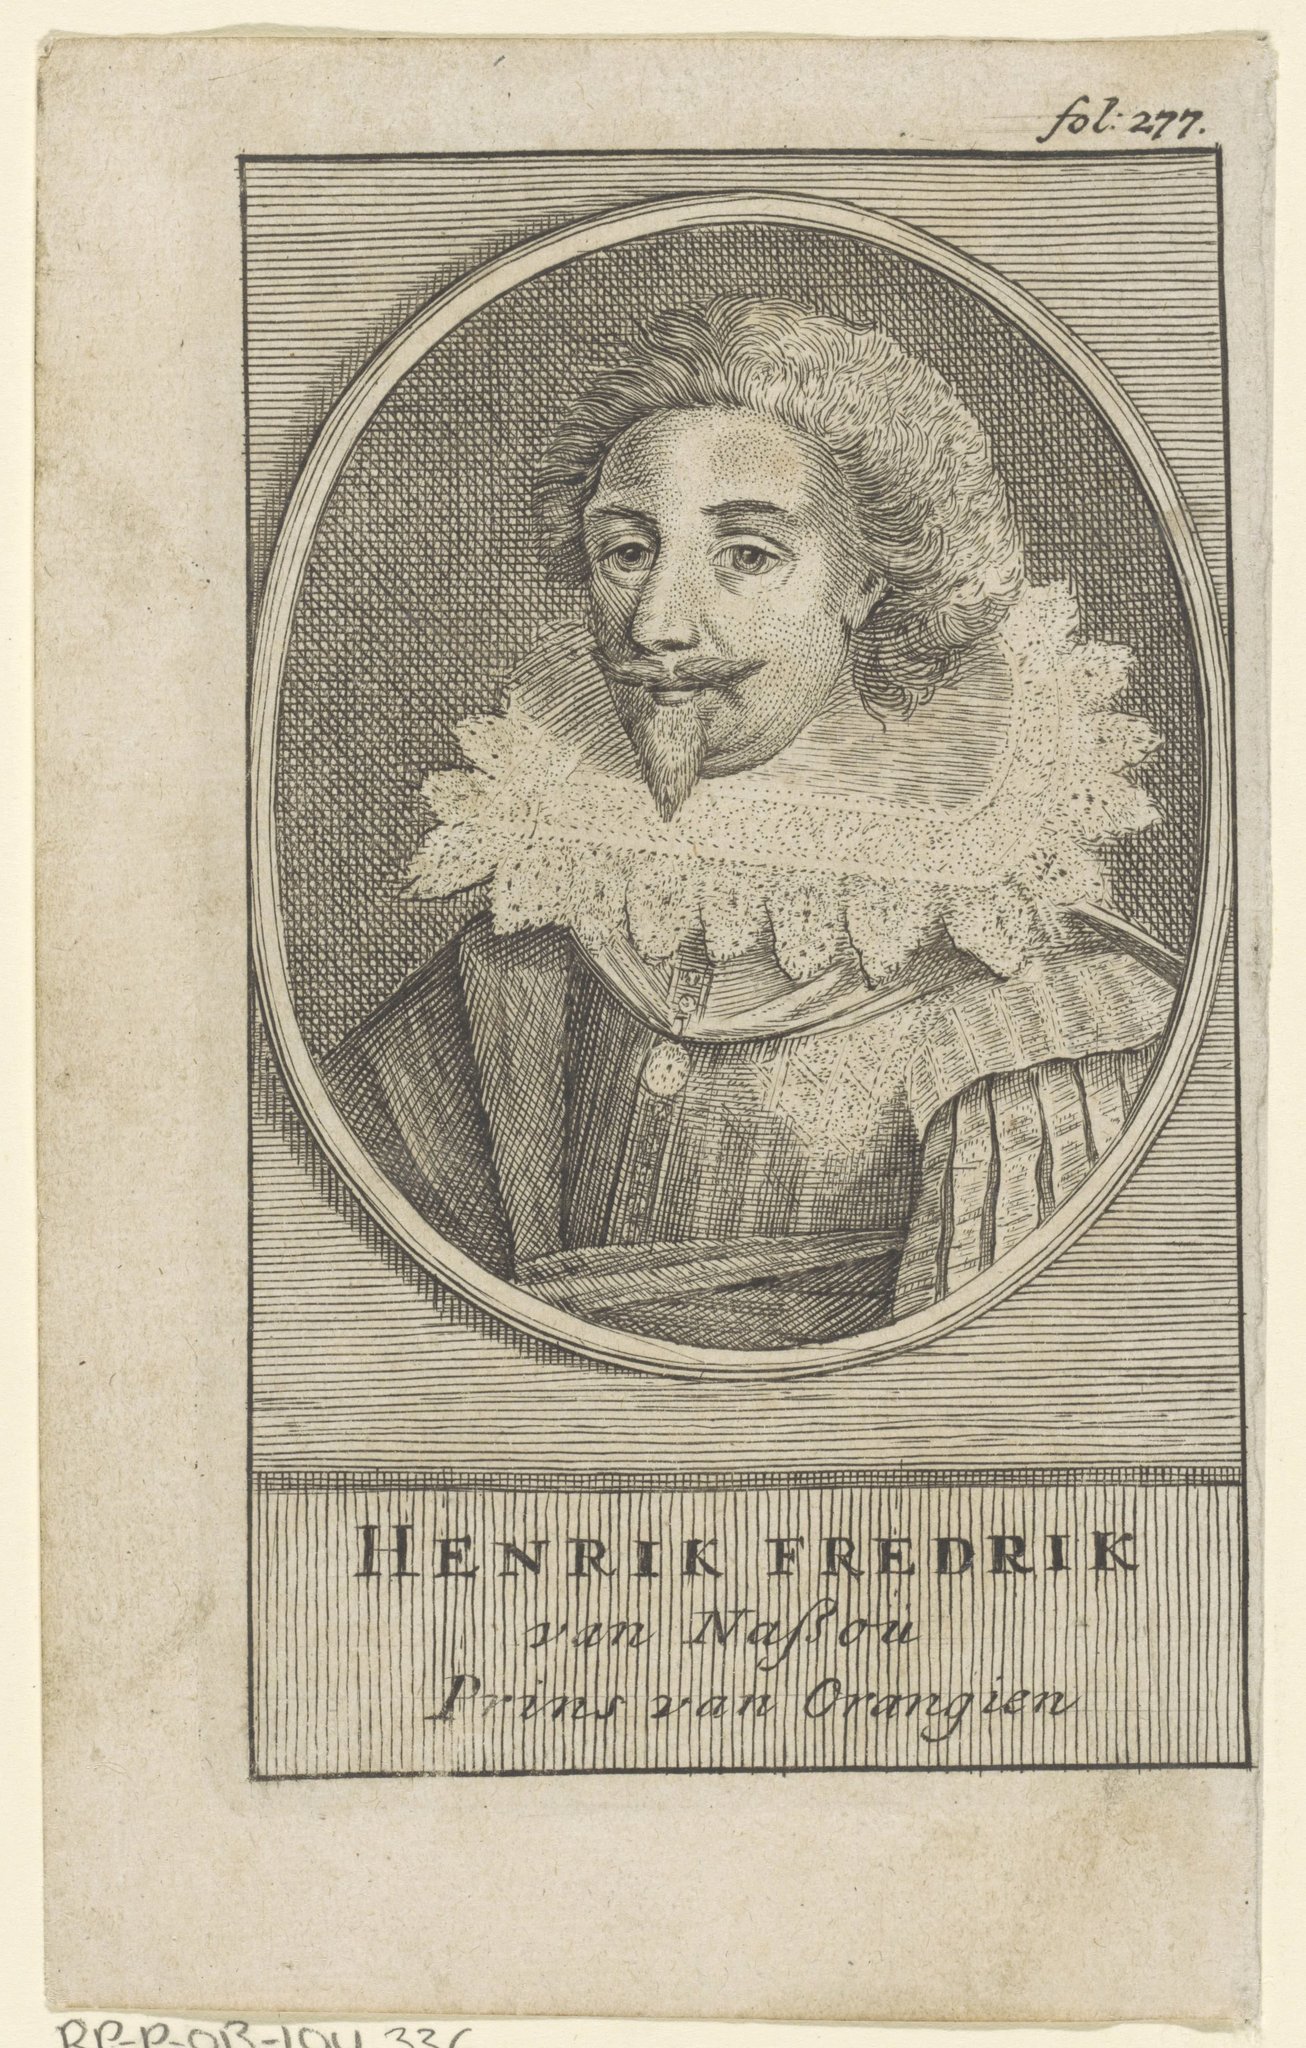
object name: print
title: Portret van Frederik Hendrik, prins van Oranje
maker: Anonymous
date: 1600-1699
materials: paper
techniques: engraving, etching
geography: low countries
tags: delft, frederick henry (prince of orange), knighthood order (garter) - insignia of a knighthood order, e.g.: badge, chain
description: De hier vermelde titel verwijst naar de hoogst verkregen titel van de geportretteerde, niet per se naar de titel die de geportretteerde op deze voorstelling draagt.